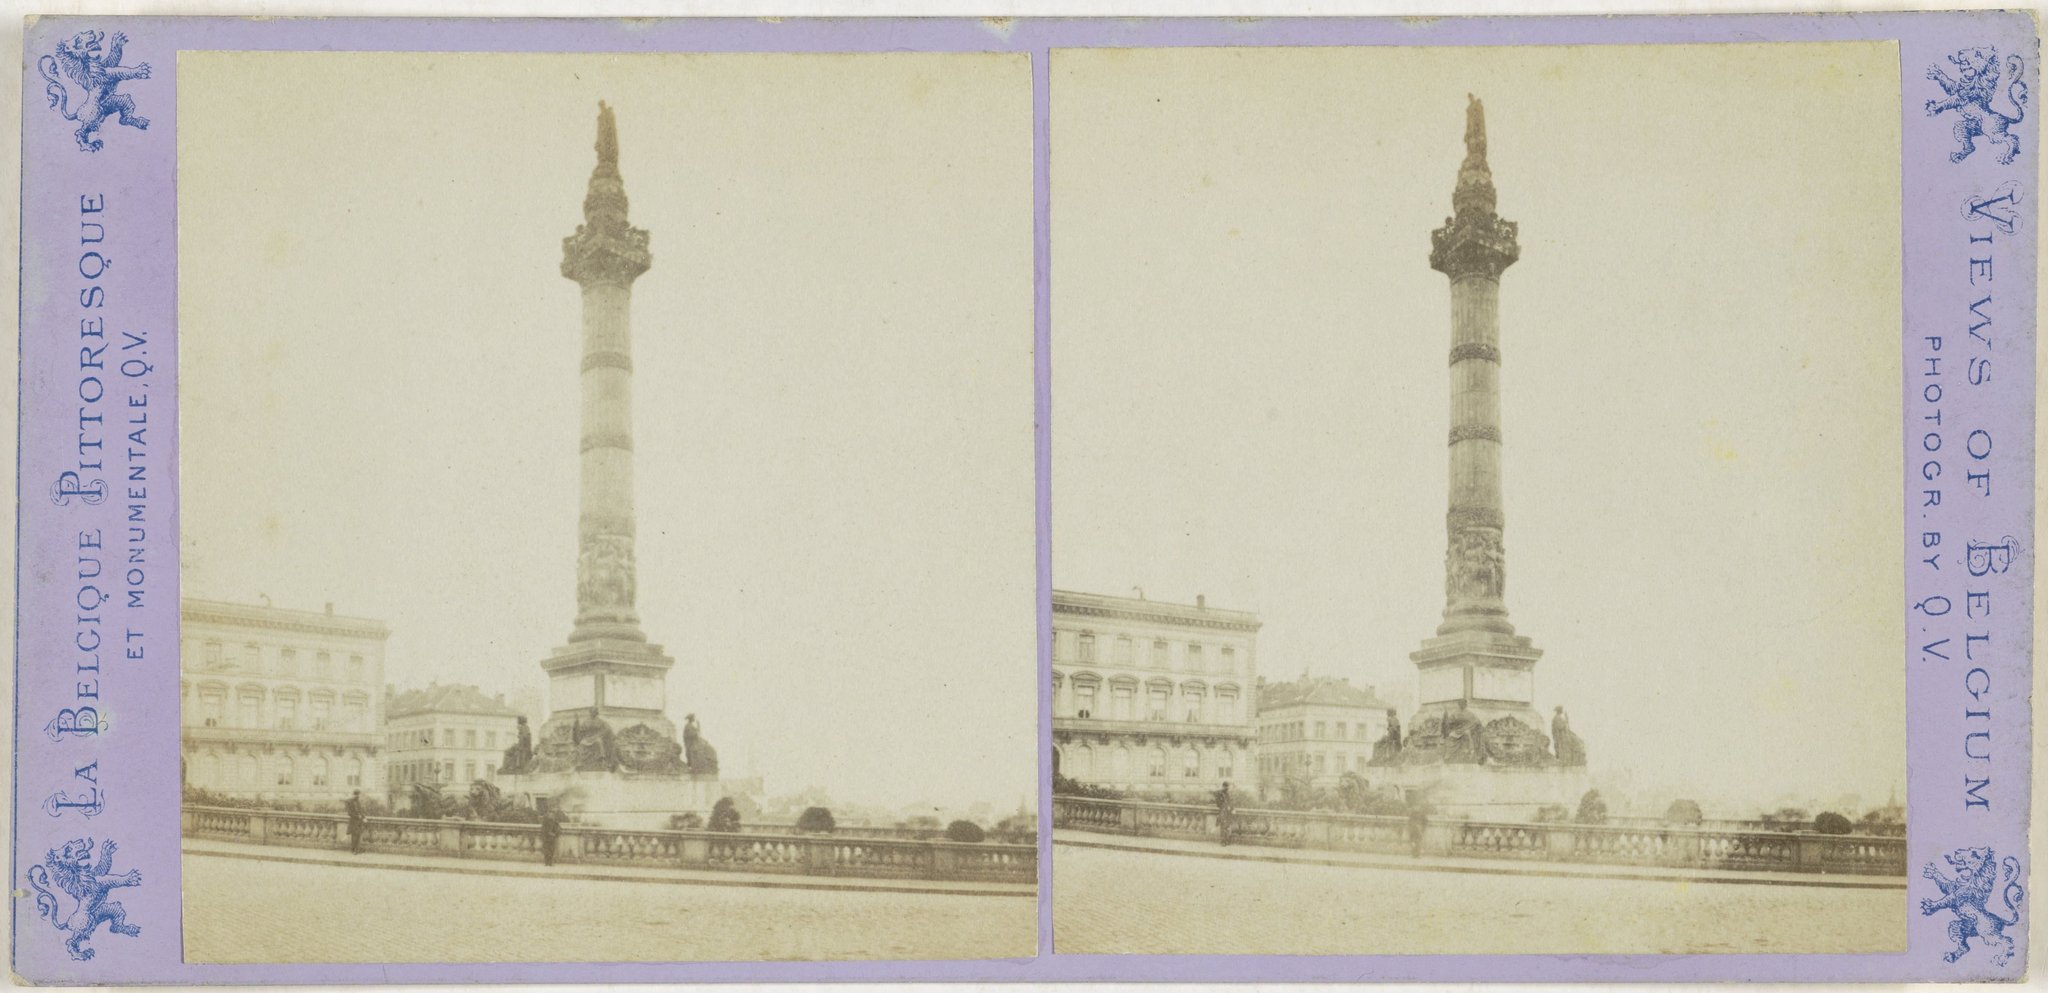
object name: stereograph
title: La Belgique pittoresque et monumentale / Views of Belgium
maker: jules hippolyte quéval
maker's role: publisher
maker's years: 1824-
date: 1866-1870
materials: cardboard, paper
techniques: albumen print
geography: brussels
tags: square, place, circus, etc., monument, statue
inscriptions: number: ‘No 1621’